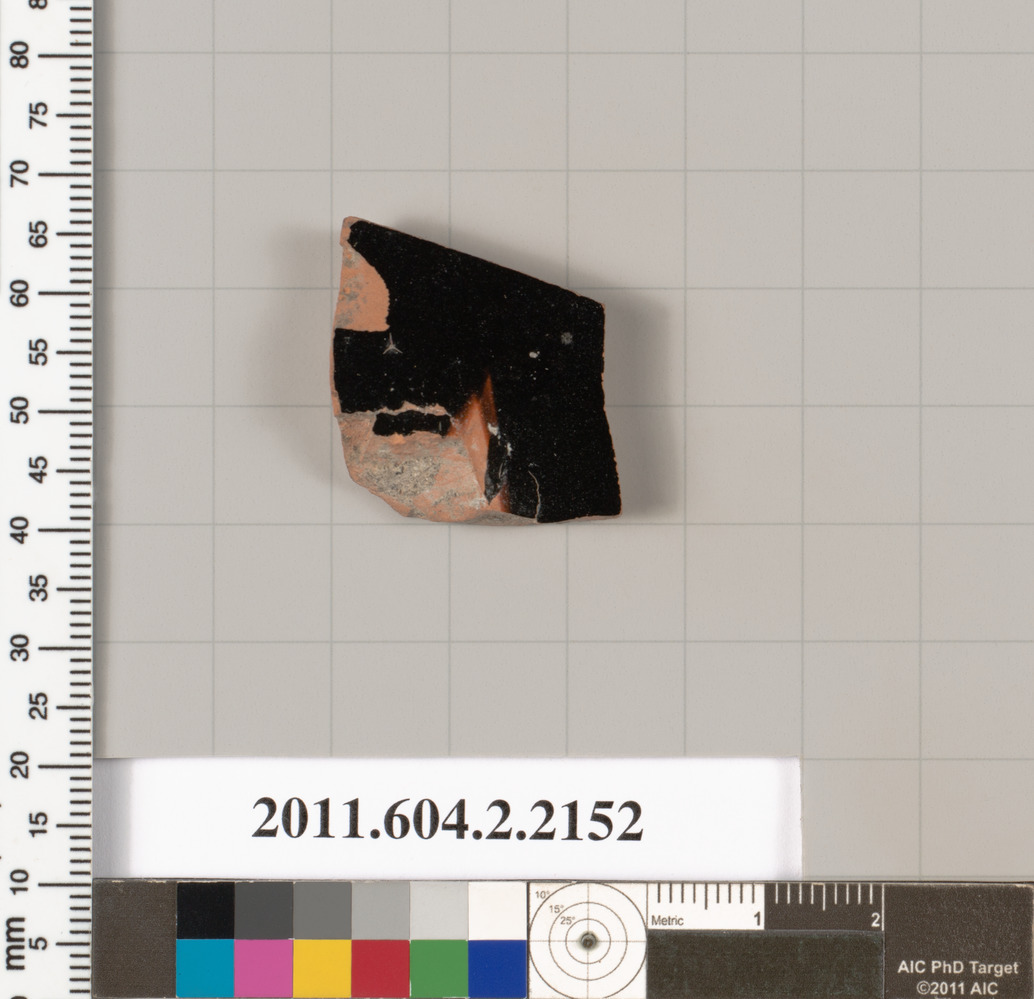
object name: pot fragment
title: Terracotta fragment of a pot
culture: greek, attic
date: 600-401 BCE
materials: terracotta